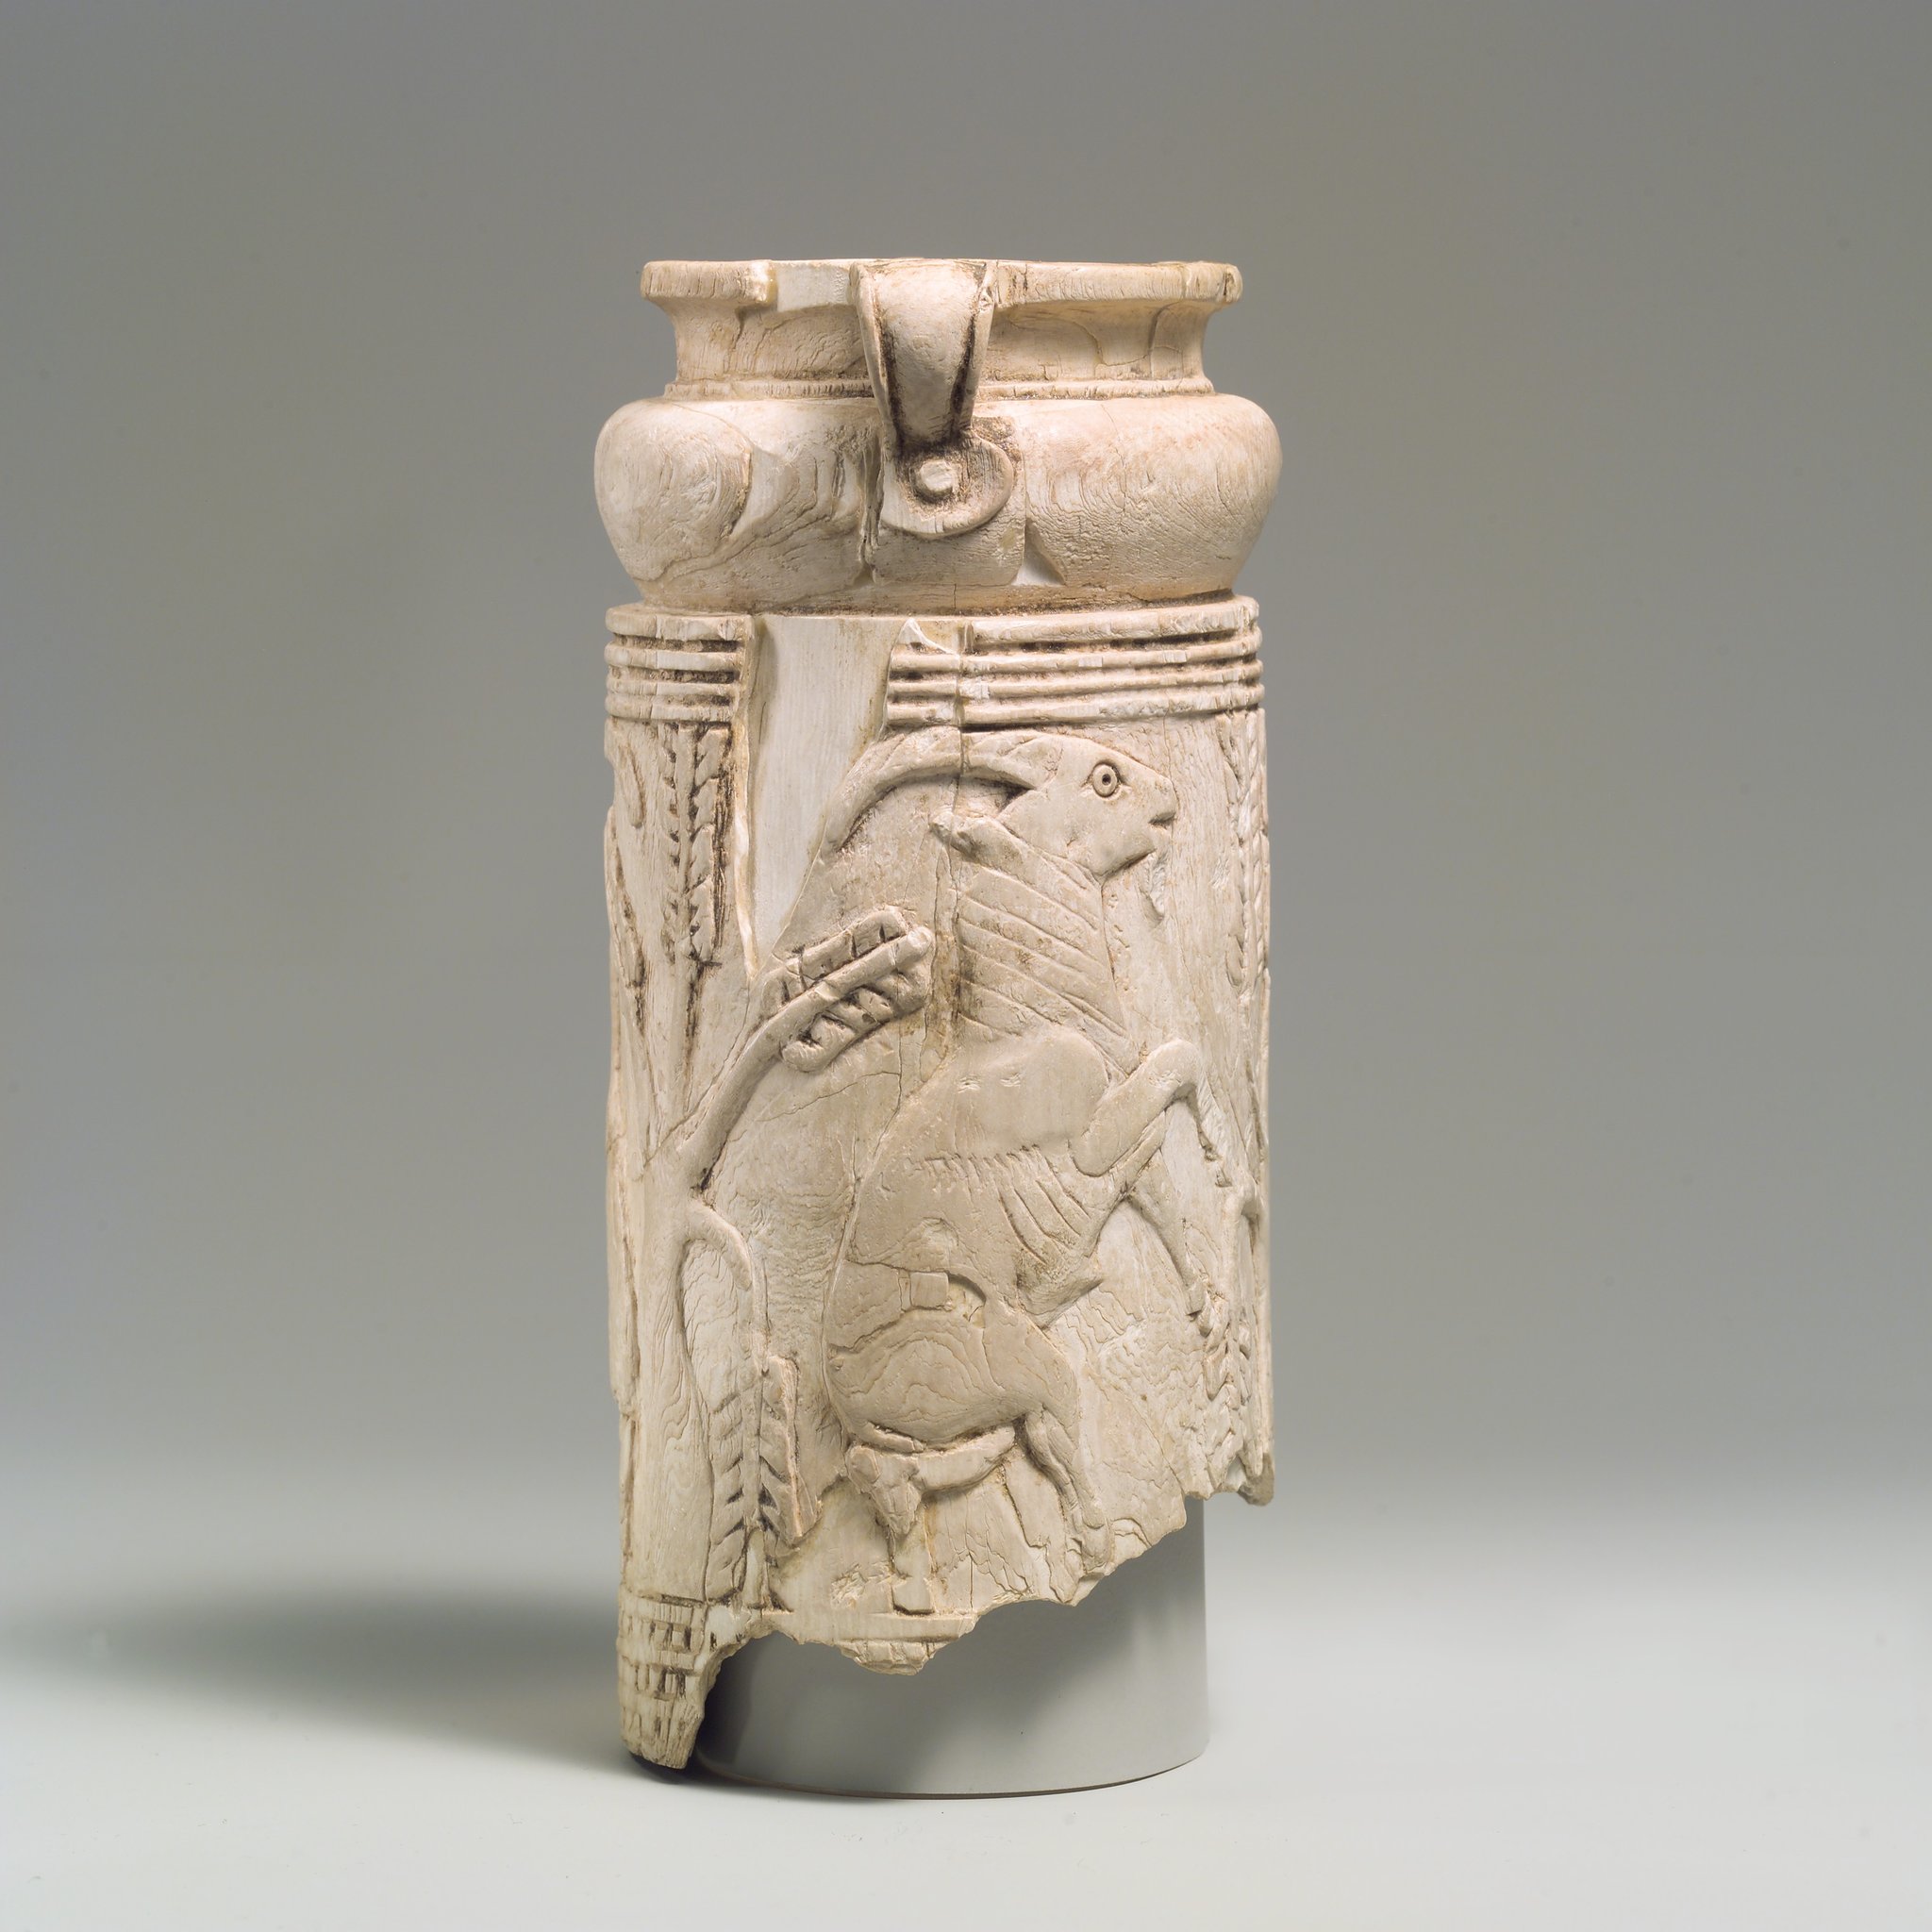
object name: vessel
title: Levantine vessel with rampant goats and olive trees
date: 1333-668 BCE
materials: ivory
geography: egypt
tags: goats,olive trees